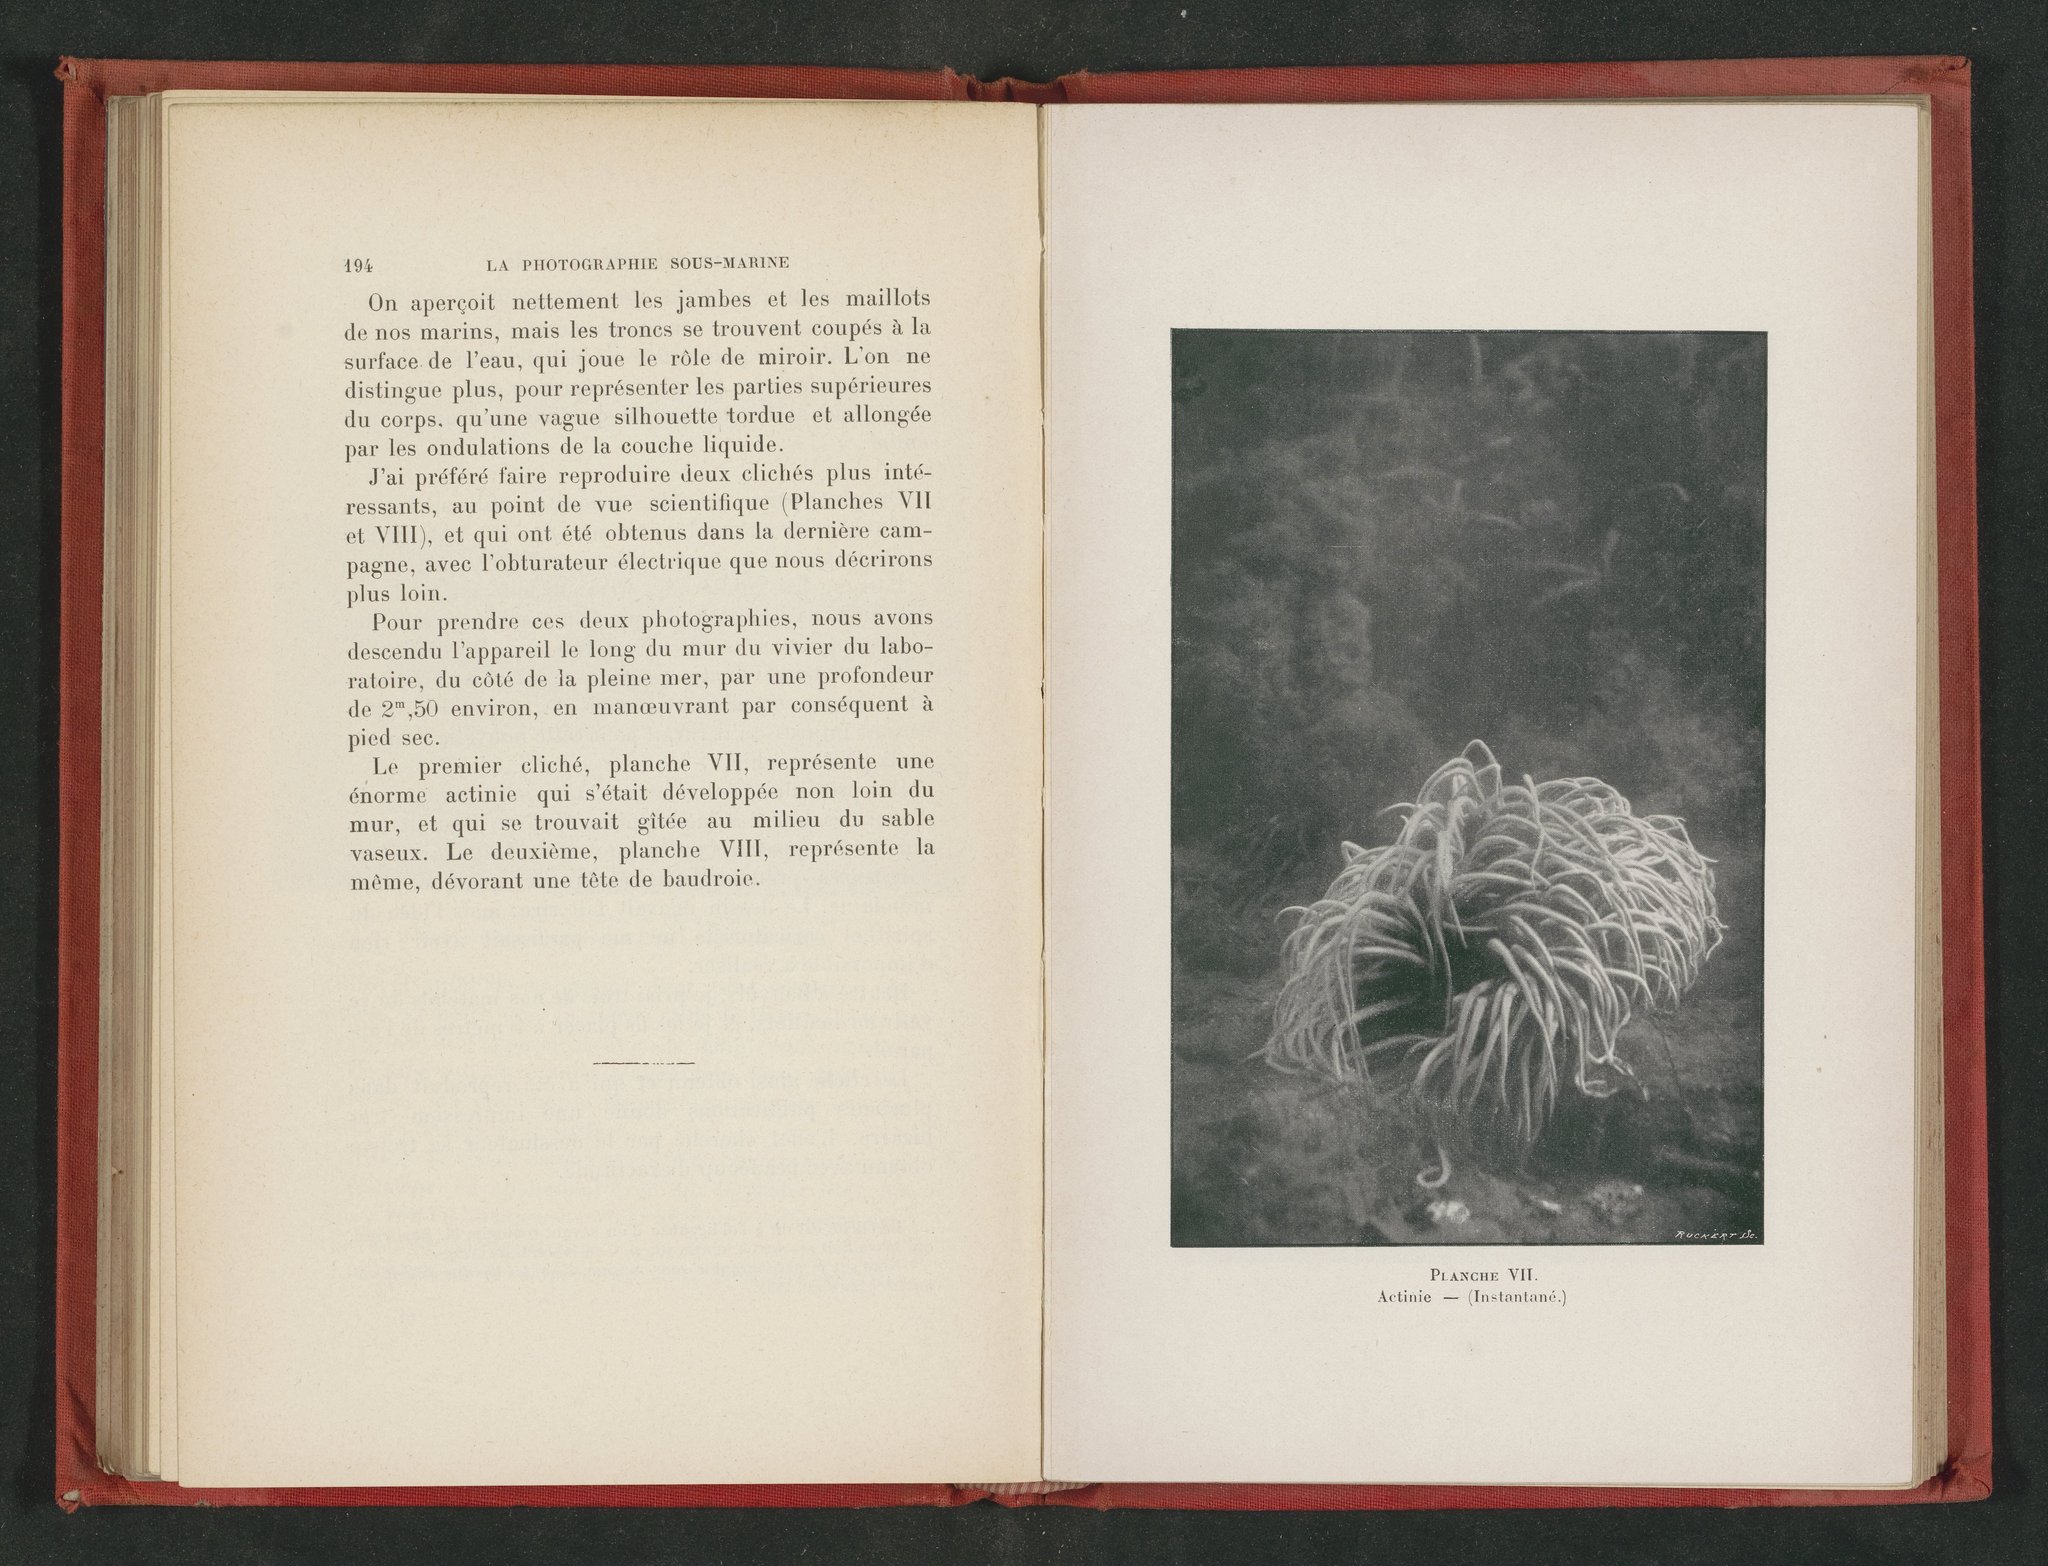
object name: page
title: Actinie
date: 1890-1900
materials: paper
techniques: autotype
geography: france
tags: coelenterata: anemone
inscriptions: number: ‘Planche VII.’